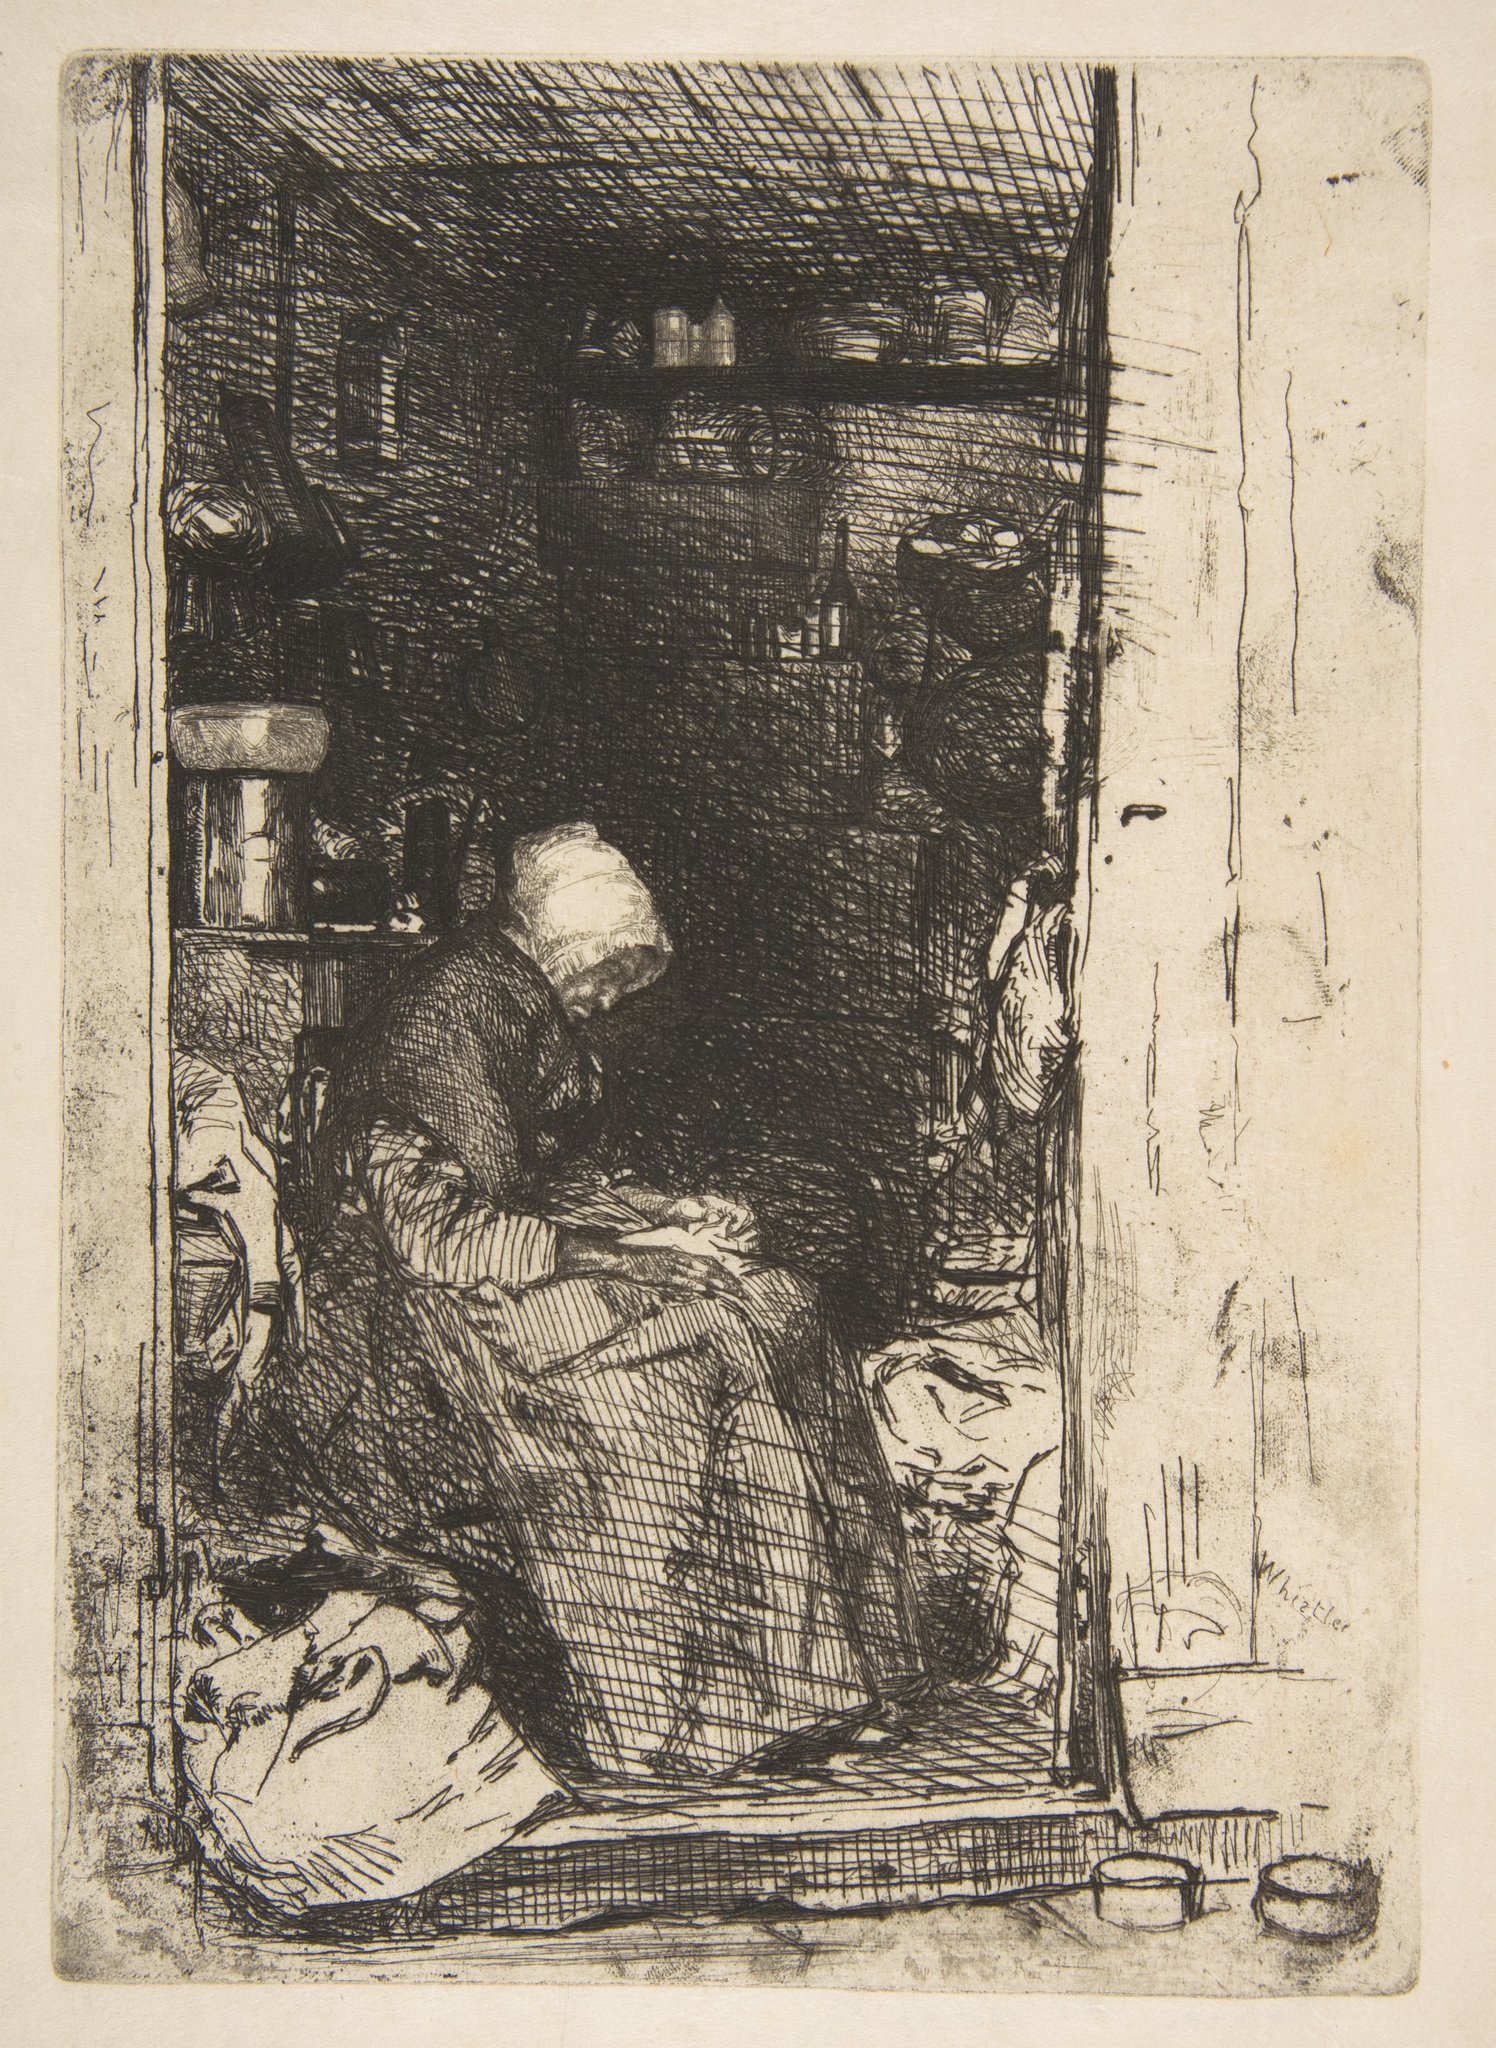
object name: print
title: La Vielle aux loques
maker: james mcneill whistler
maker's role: artist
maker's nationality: american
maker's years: 1834-1903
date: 1858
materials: ink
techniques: drypoint, etching, printing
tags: women